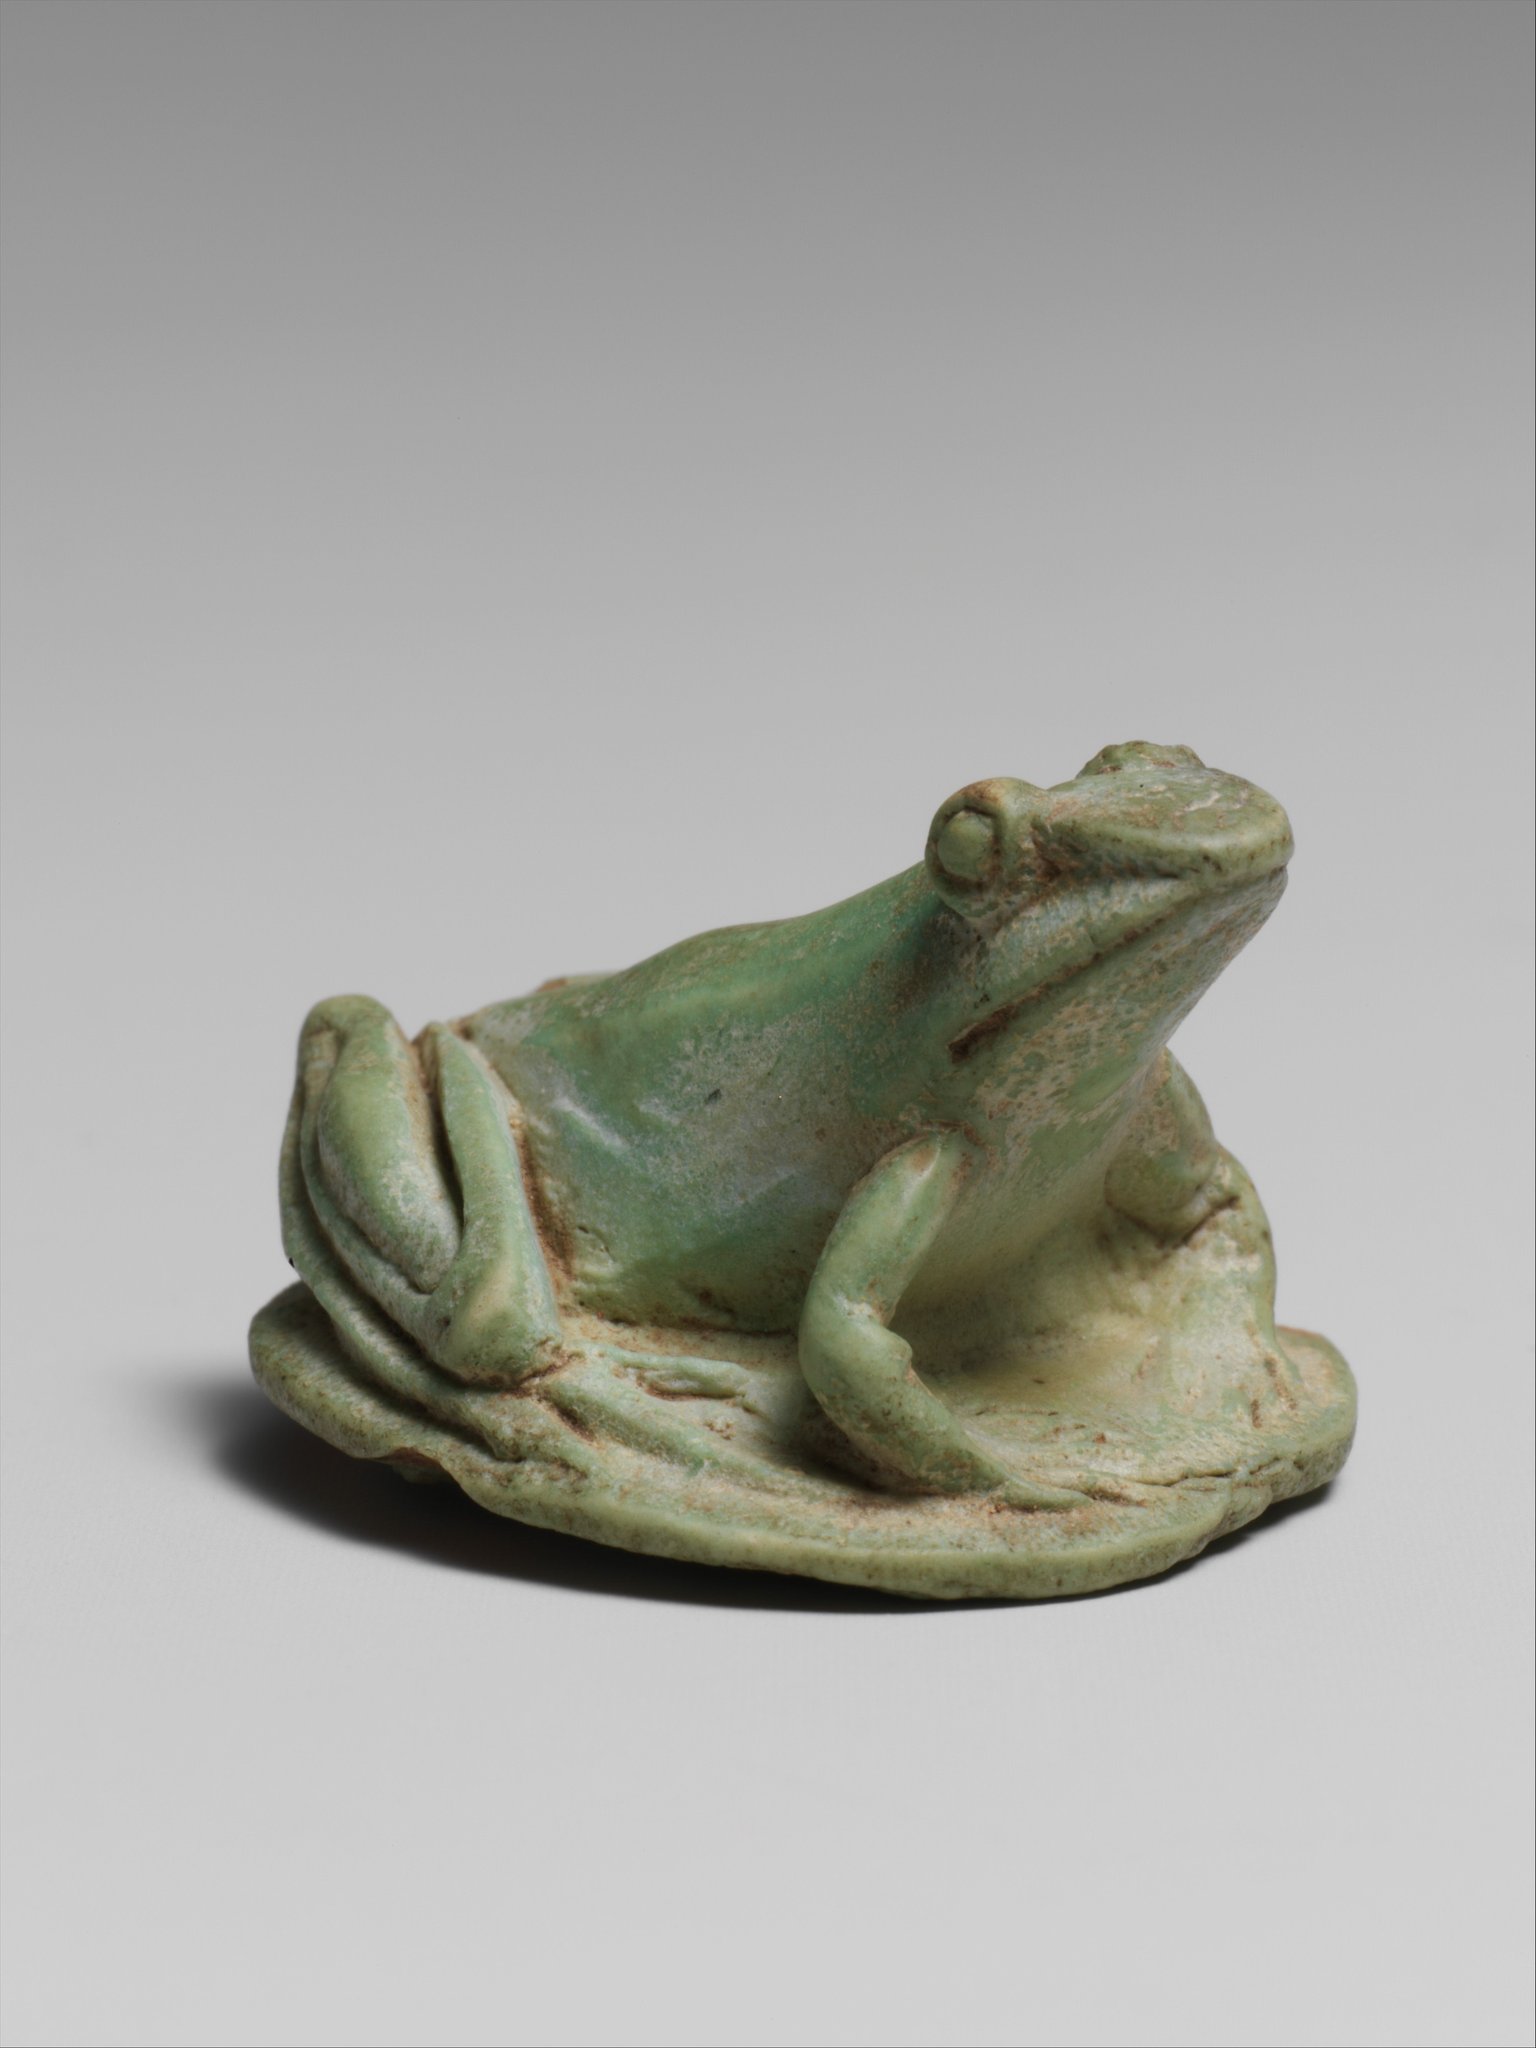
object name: amulet, frog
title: Faience amulet in the form of a tree frog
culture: egyptian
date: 330-30 BCE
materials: faience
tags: frogs